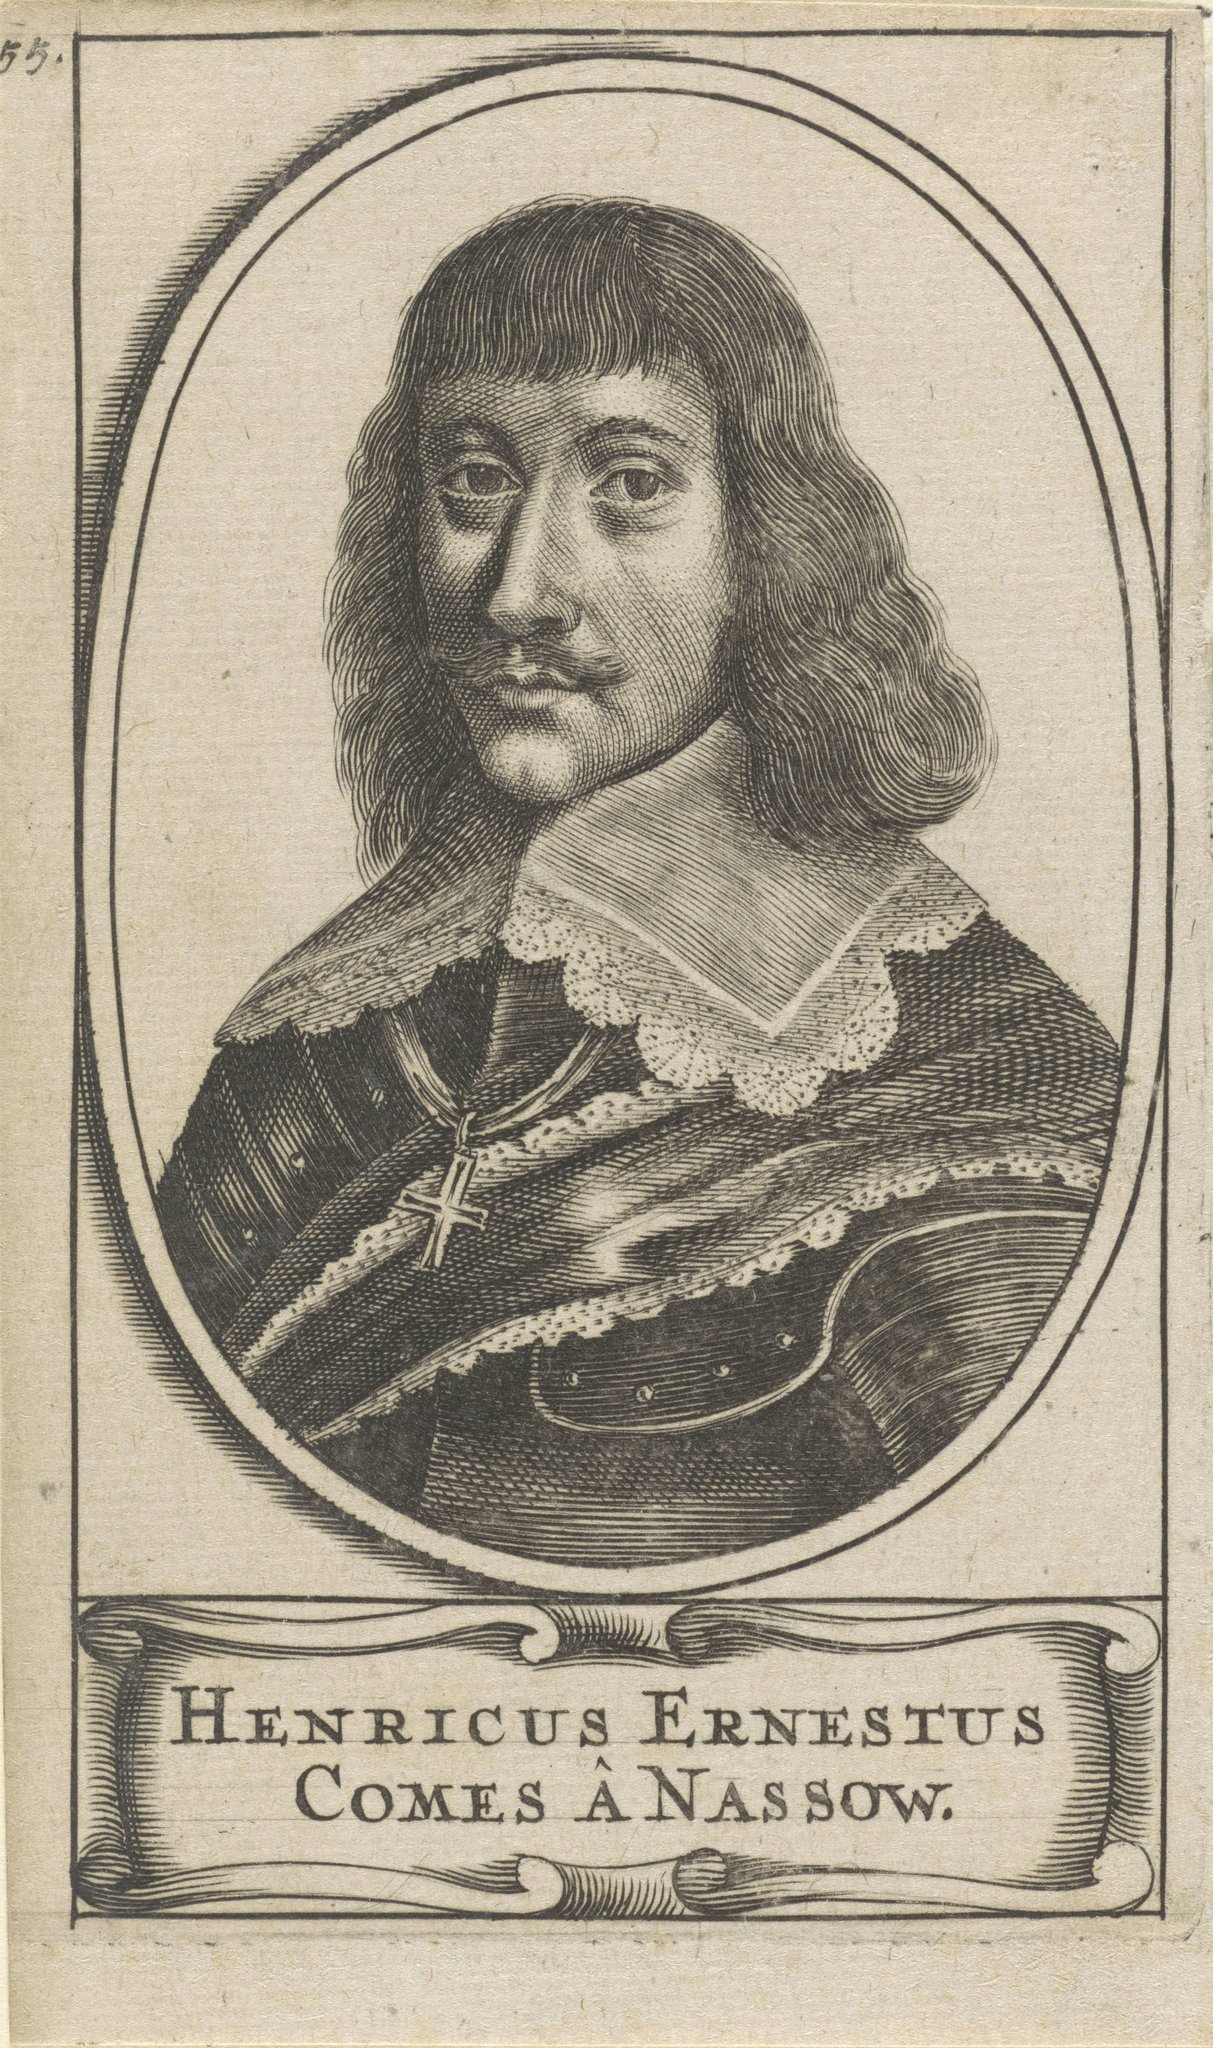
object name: book illustration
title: Portret van Hendrik Casimir I, graaf van Nassau-Dietz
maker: Anonymous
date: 1630-1699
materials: paper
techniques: engraving, etching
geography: low countries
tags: arnhem, hendrik casimir i graaf van nassau-dietz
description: De hier vermelde titel verwijst naar de hoogst verkregen titel van de geportretteerde, niet per se naar de titel die de geportretteerde op deze voorstelling draagt.